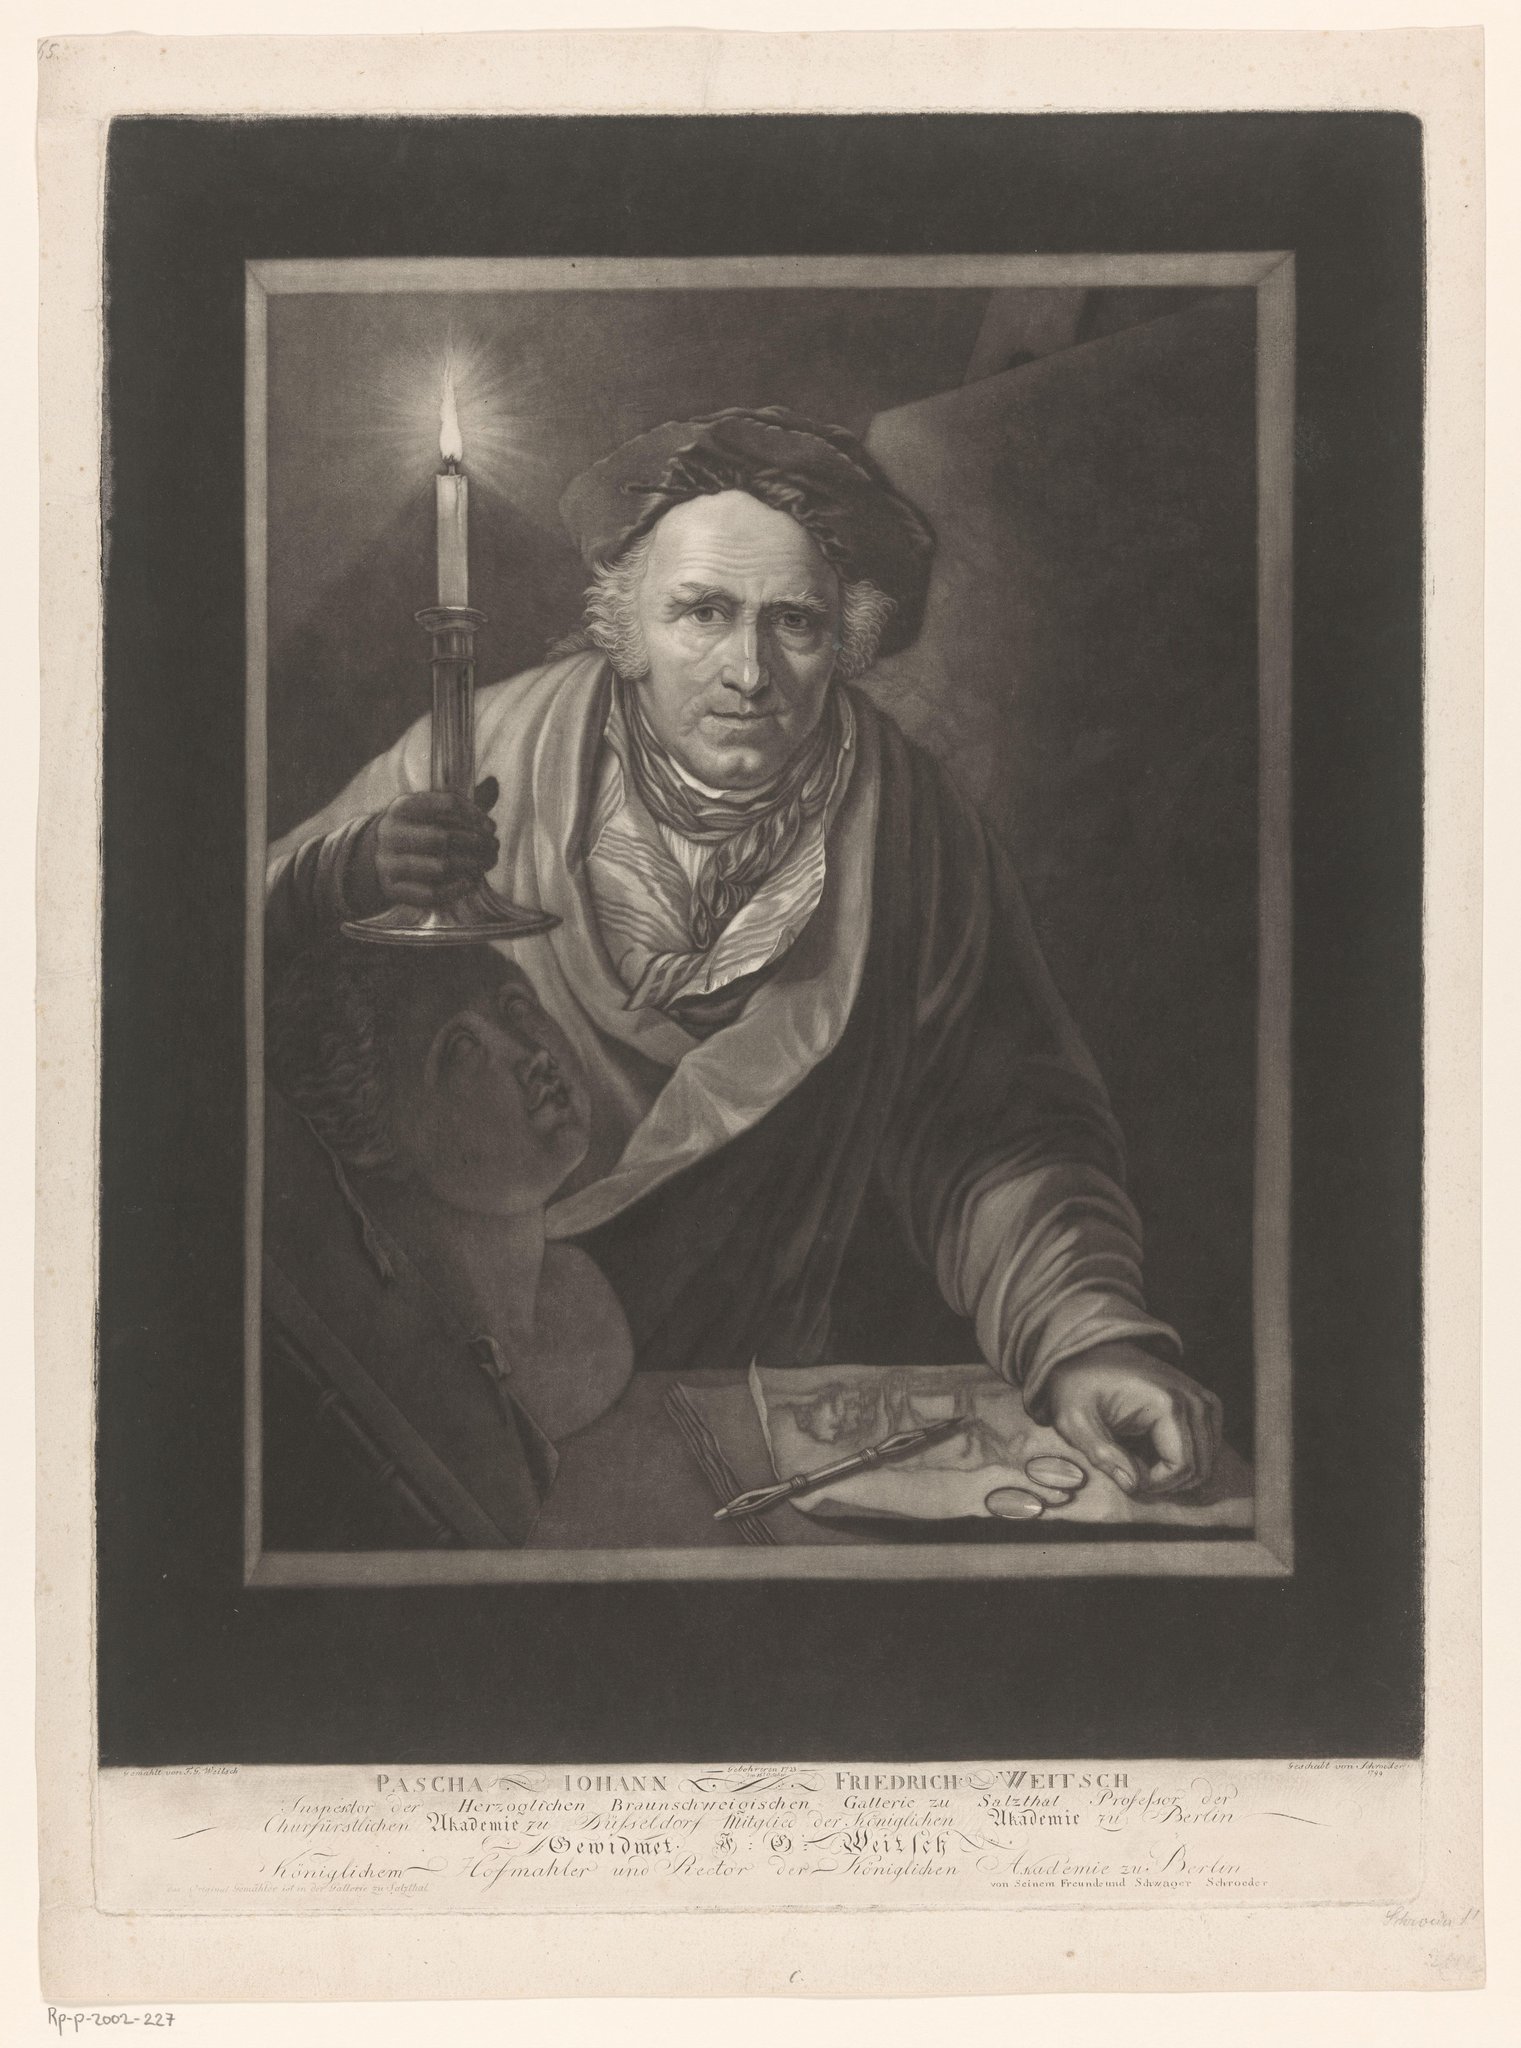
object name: print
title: Portret van Pascha Johann Friedrich Weitsch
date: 1799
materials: paper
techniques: mezzotint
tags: draughtsman, pascha johann friedrich weitsch, portrait, self-portrait of painter, candlestick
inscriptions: collector's mark: Lugt 2228, collector's mark: Lugt 2760, collector's mark: Lugt 1092a